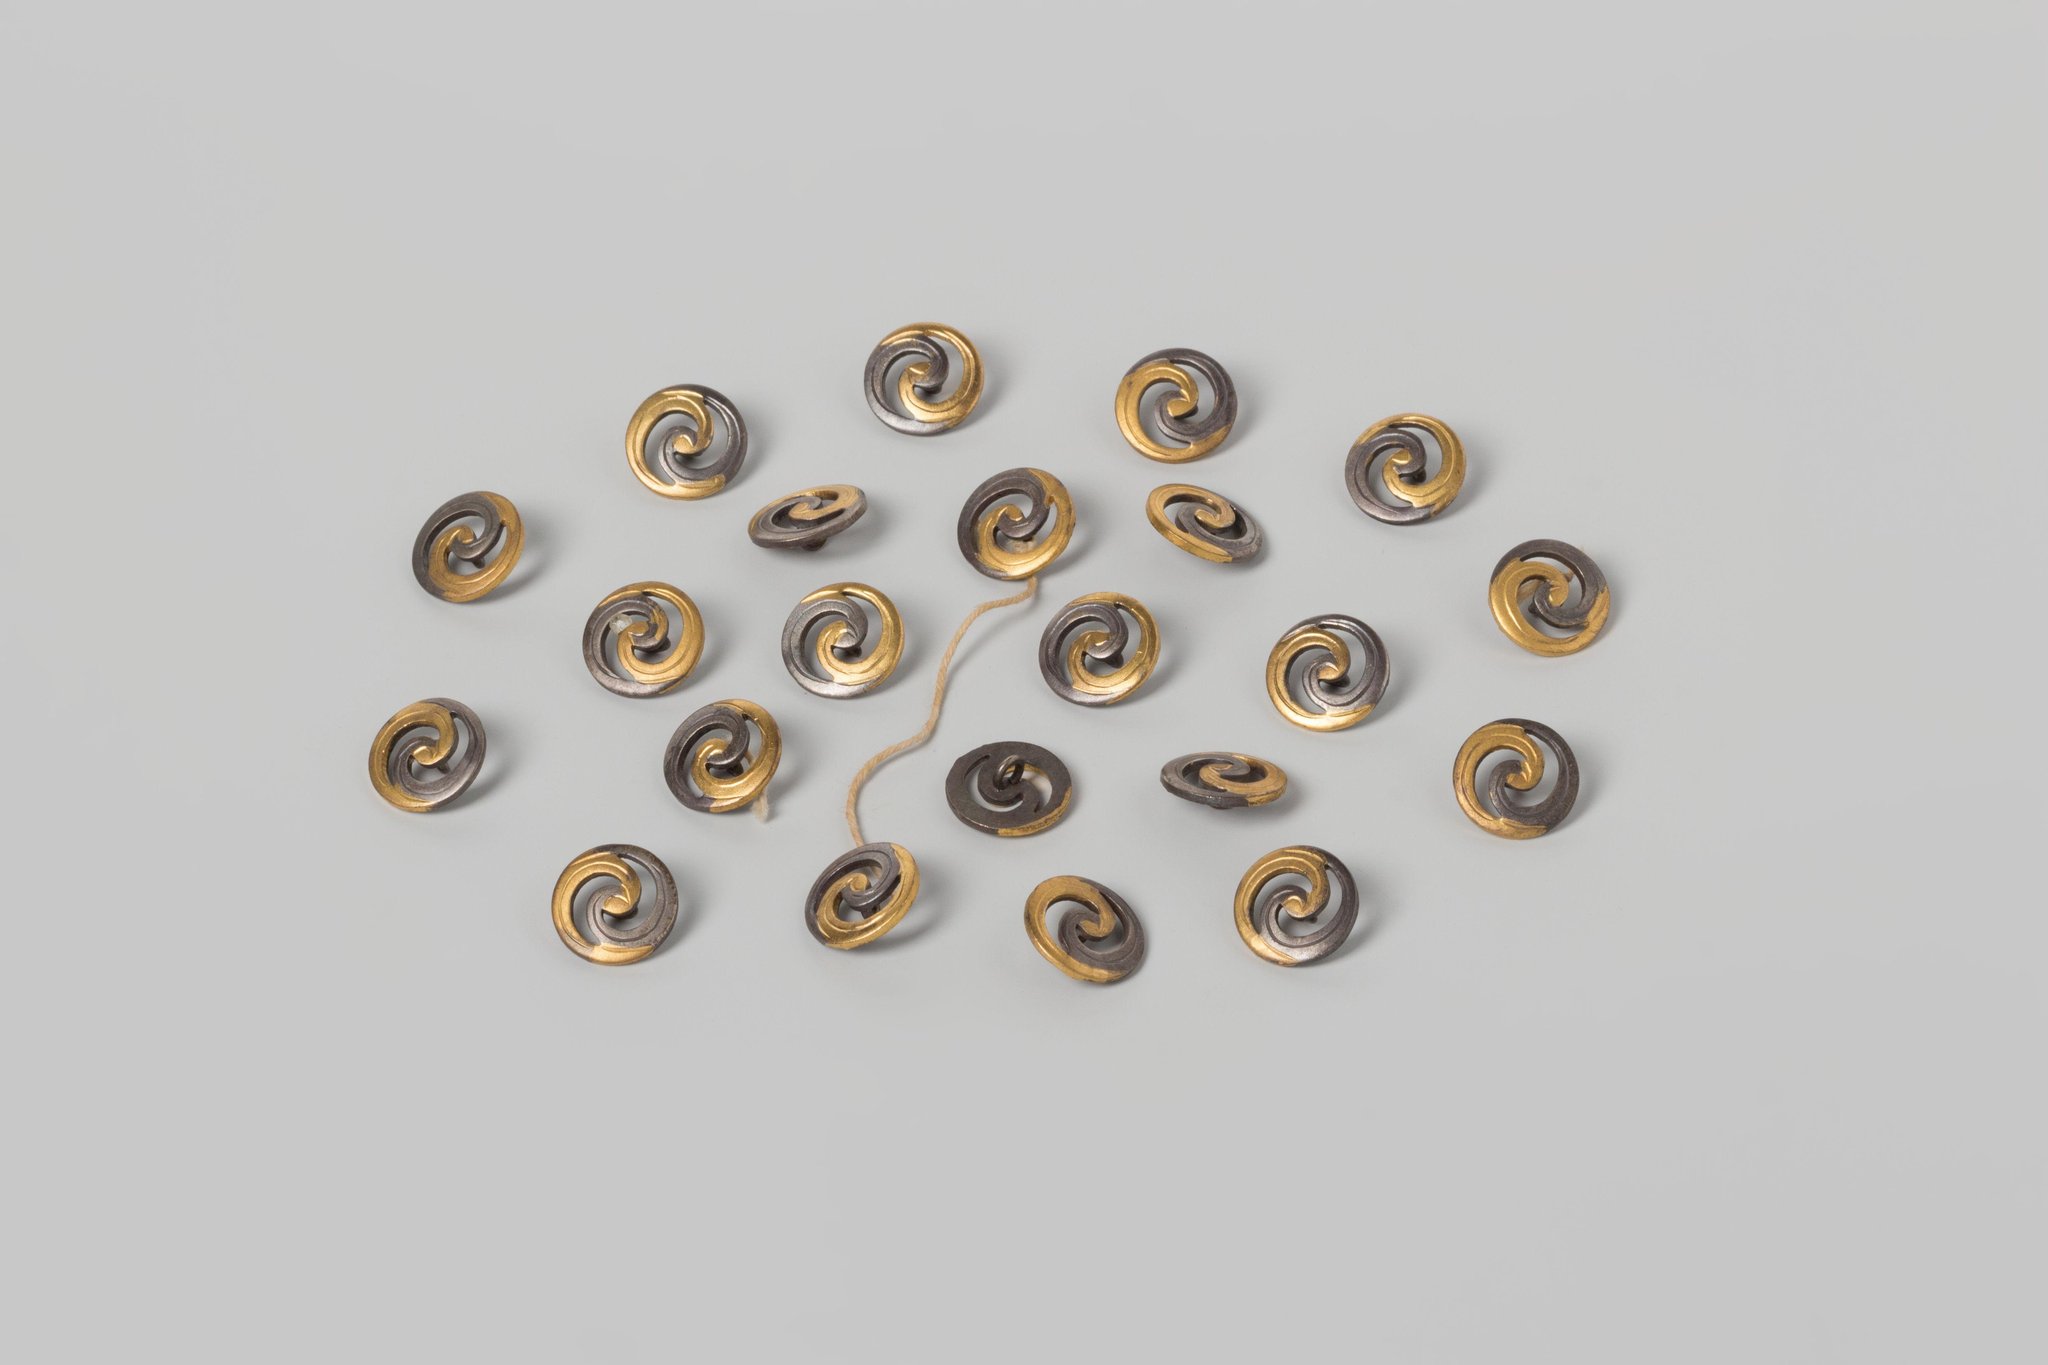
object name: button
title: Knoop, plat en rond, van gedeeltelijk met goudverf beschilderd metaal met krulmotief, gelijkend yin en yang, opengewerkt en gegraveerd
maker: Anonymous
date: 1880-1940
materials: paint, metal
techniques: embroidery, engraving, painting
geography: europe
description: Knoop, plat en rond, van gedeeltelijk met goudverf beschilderd metaal met krulmotief, gelijkend yin en yang, opengewerkt en gegraveerd.